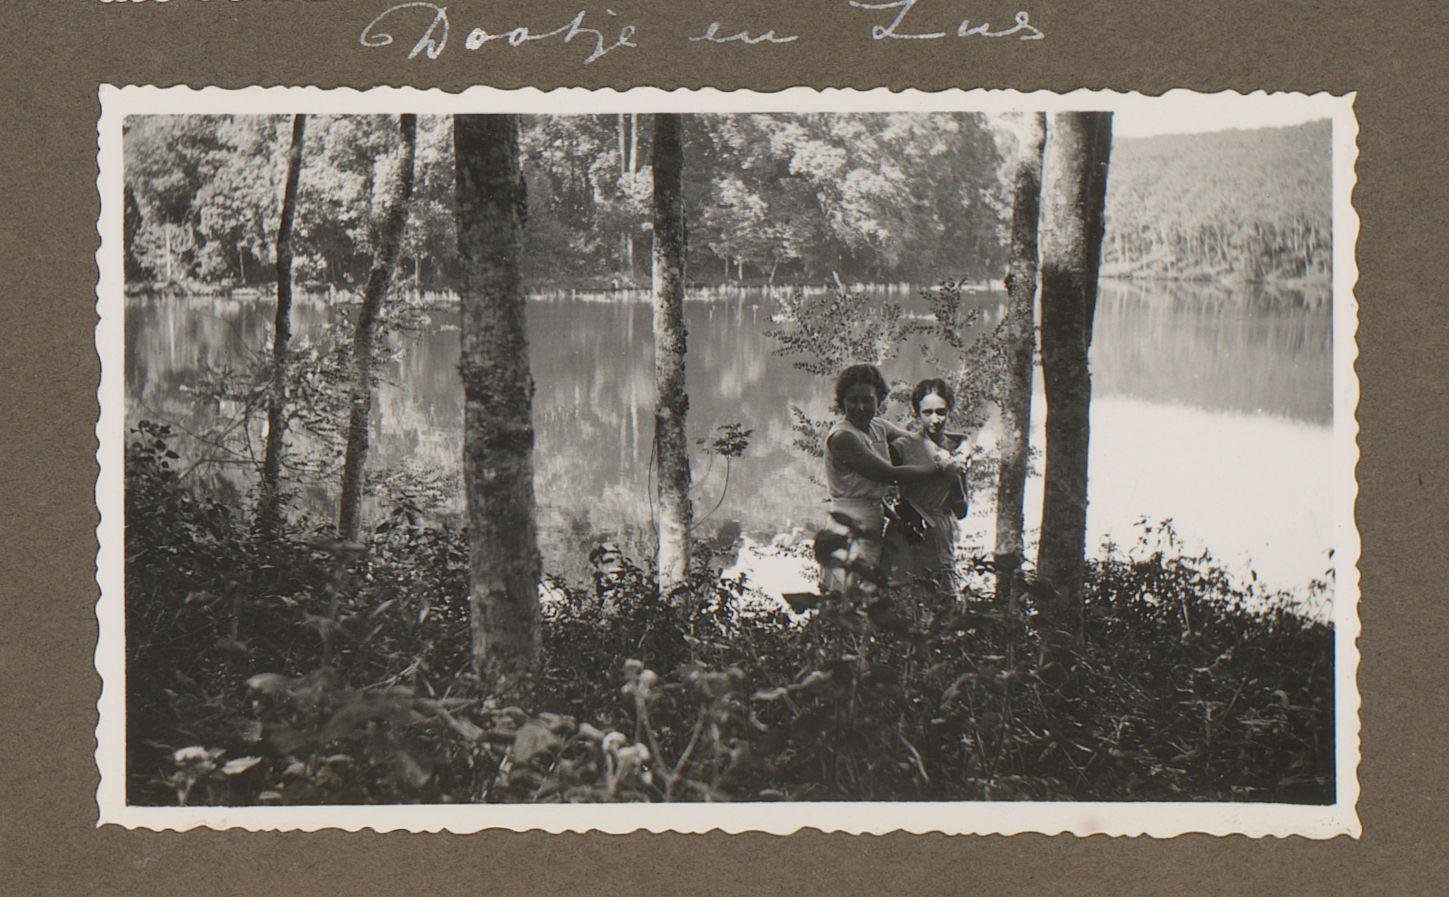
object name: album leaf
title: Dootje van Zijll de Jong en een vrouw bij een meer, nabij Bandoeng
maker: Anonymous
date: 1933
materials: paper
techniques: gelatin silver print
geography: west java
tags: historical persons - bb - woman, lake